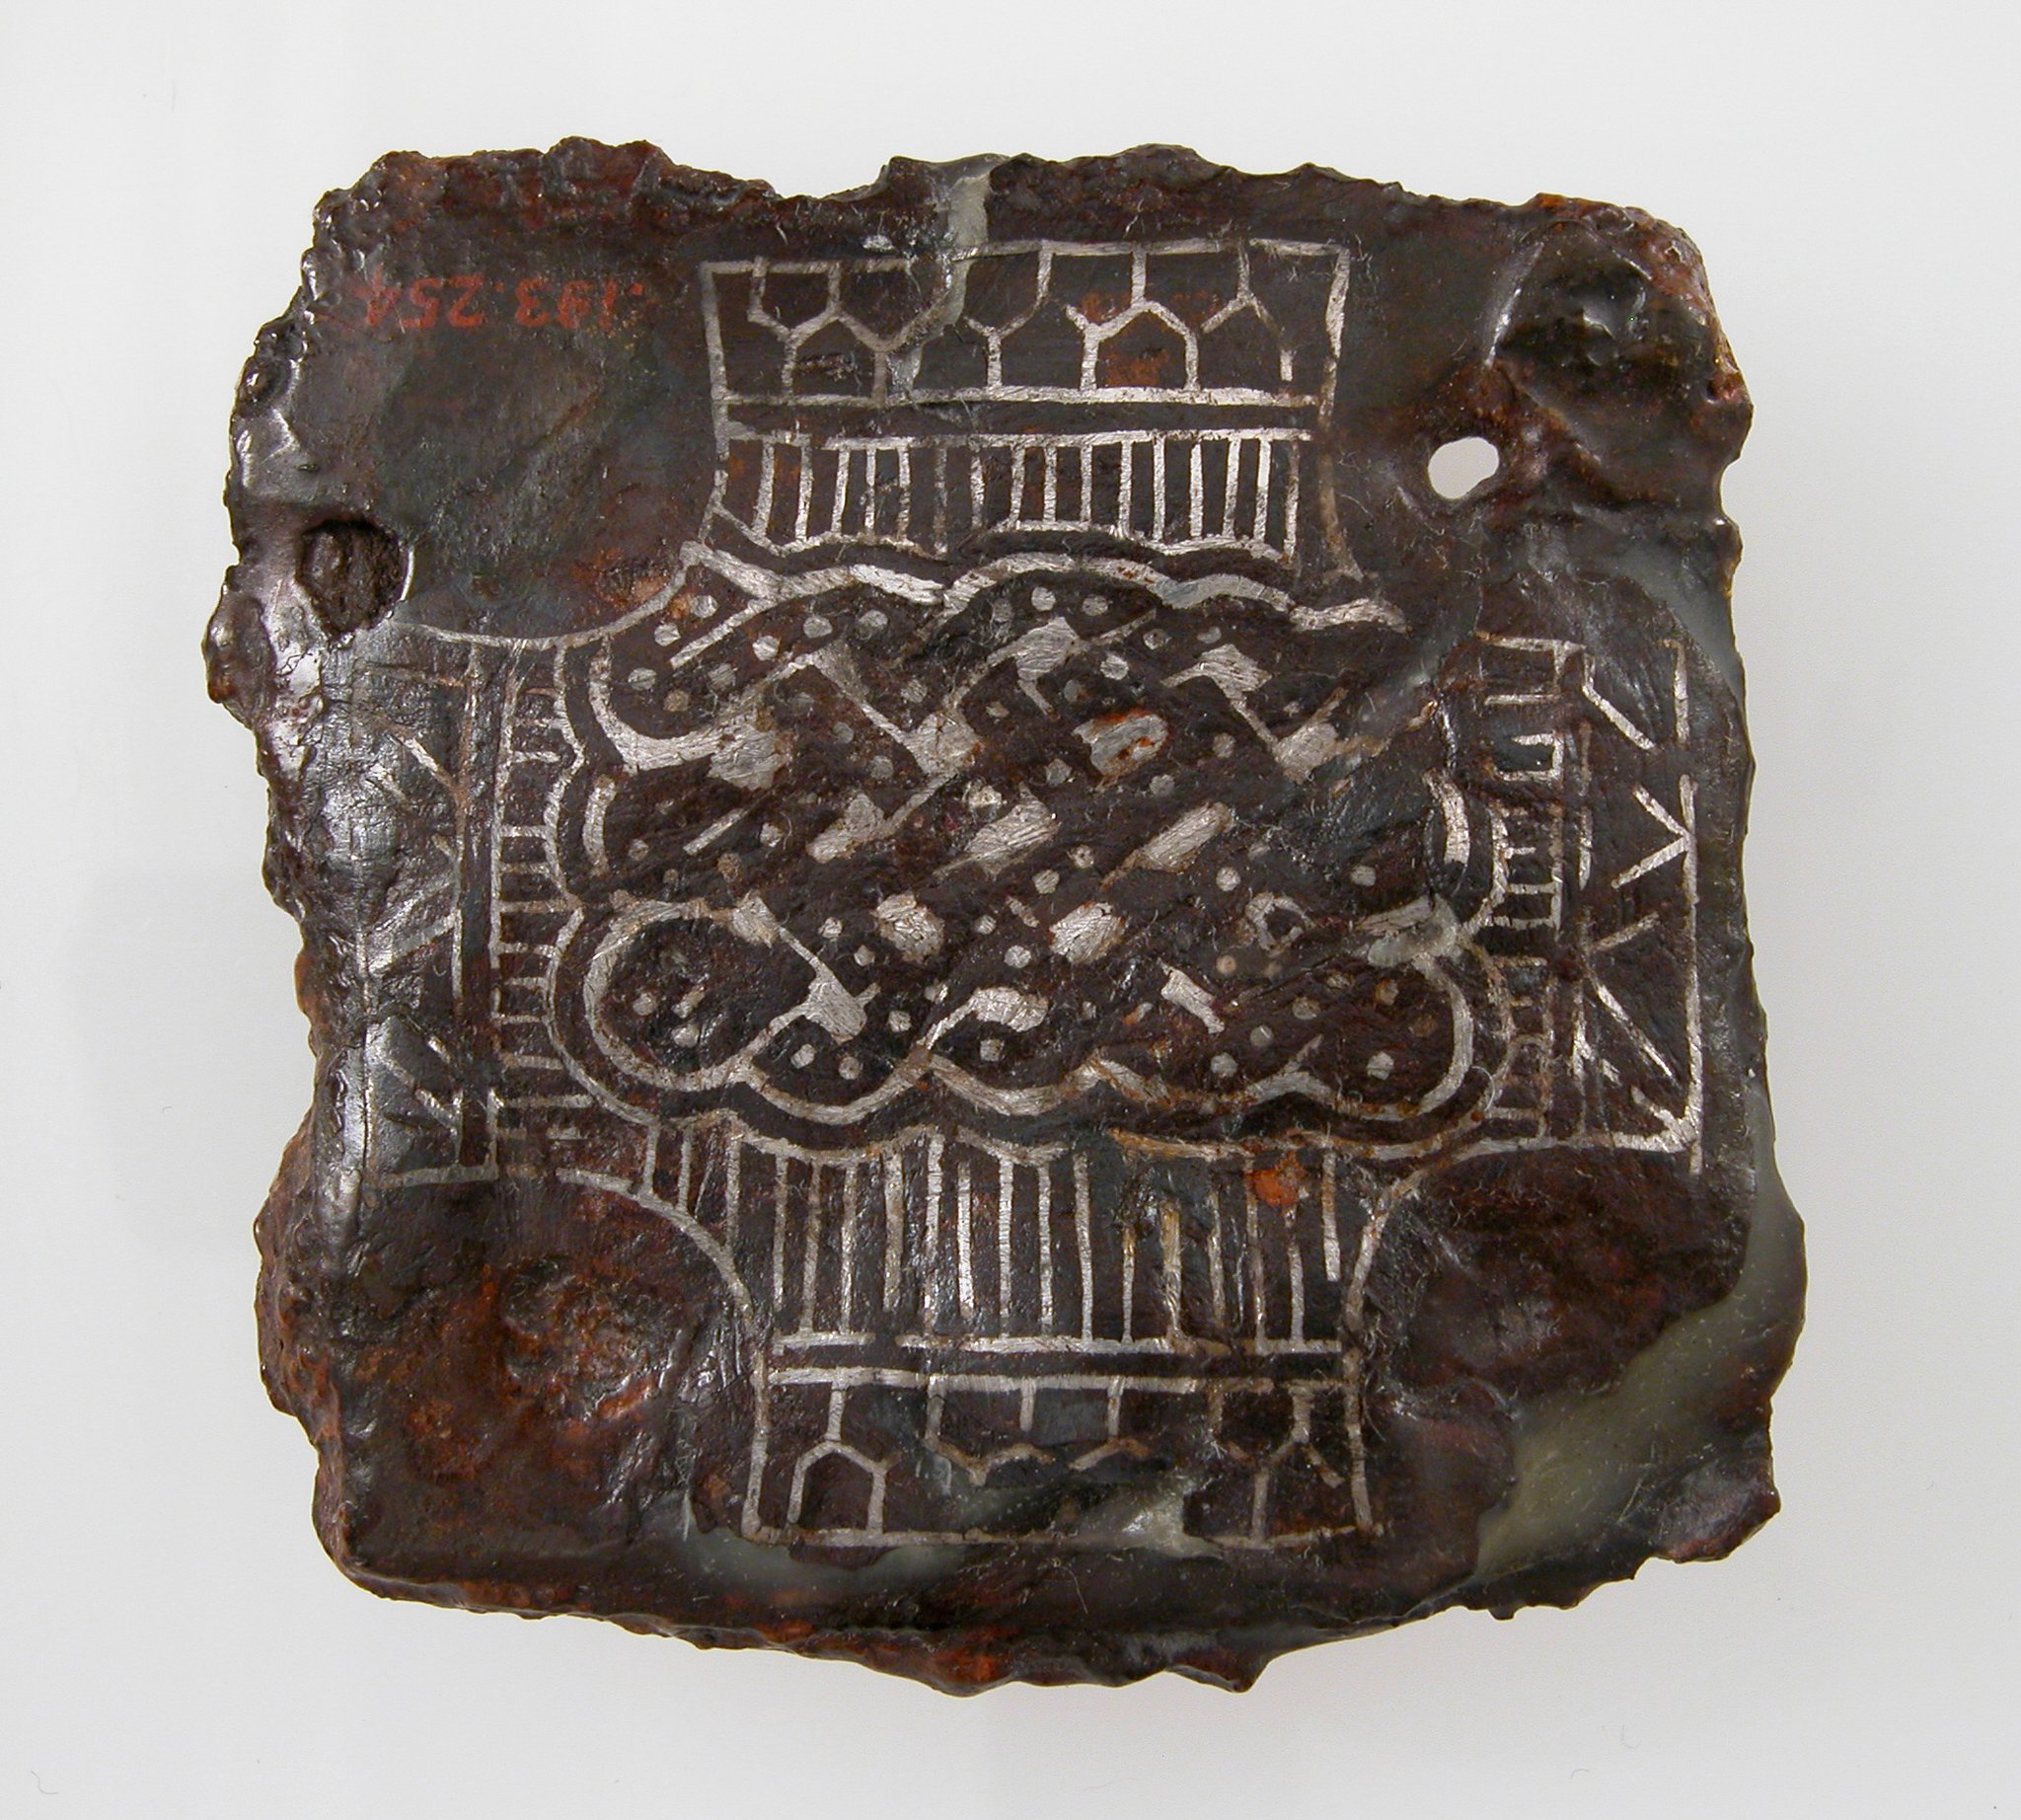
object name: belt plate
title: Backplate of a Belt Buckle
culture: frankish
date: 501-700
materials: iron, silver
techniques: inlay